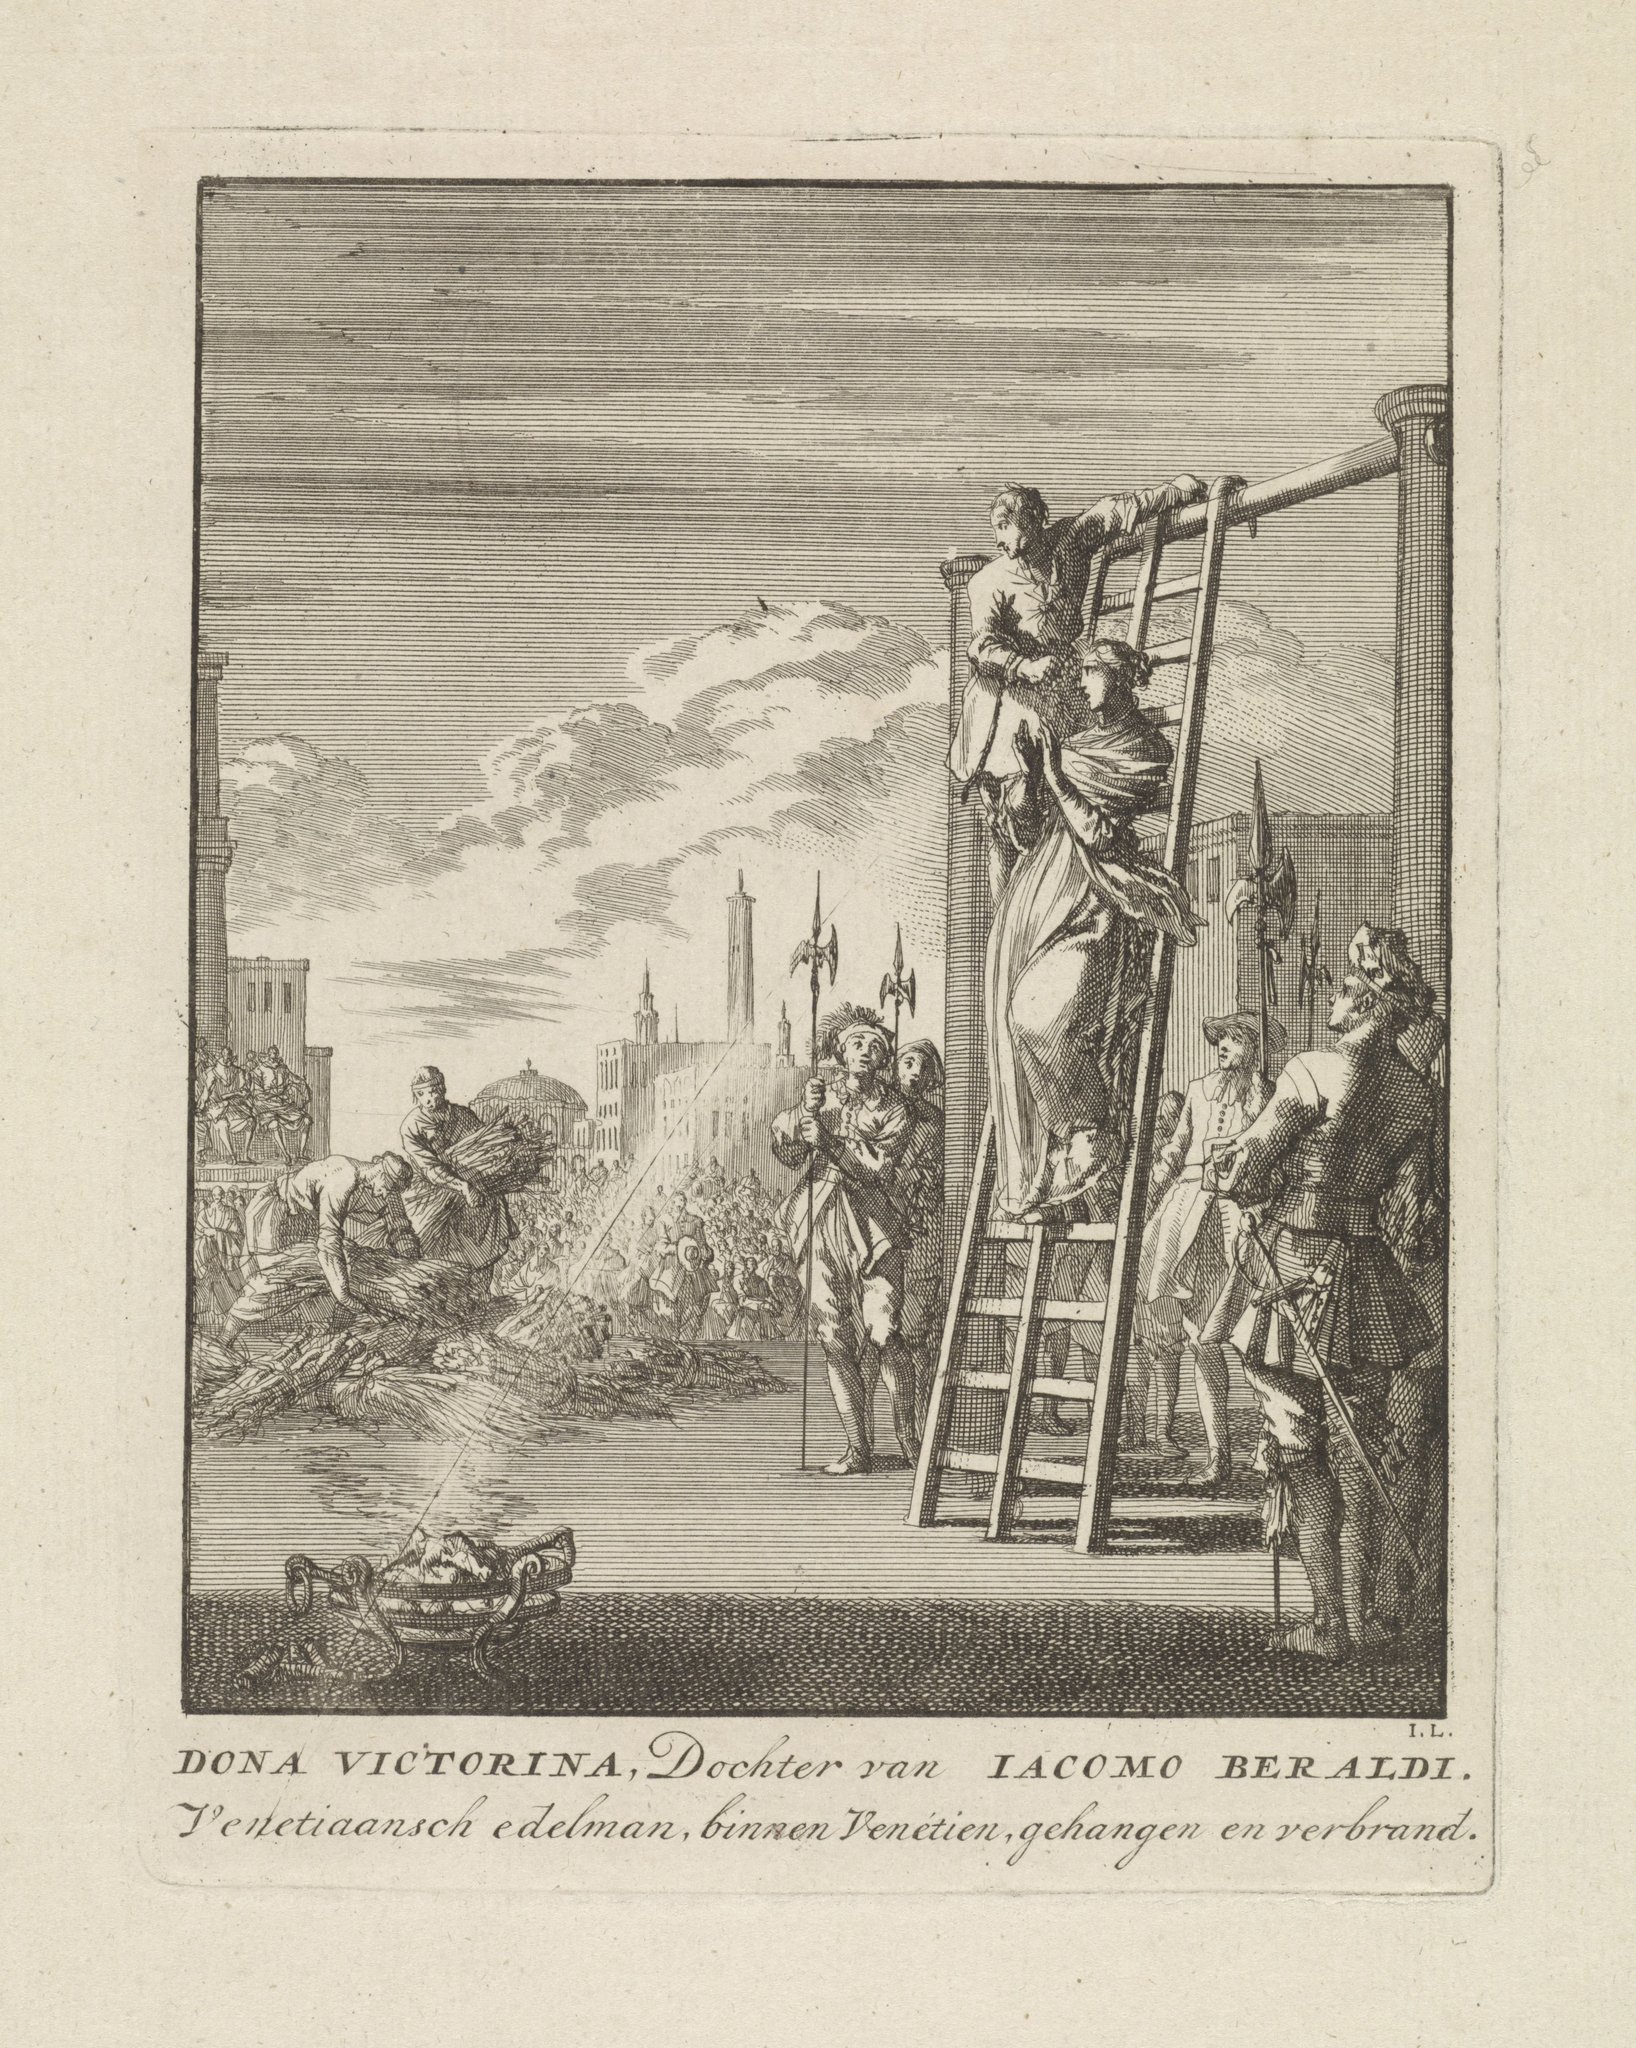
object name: history print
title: Dona Victorina, Dochter van Jacomo Beraldi, Venetiaansch edelman, binnen Venetien, gehangen en verbrand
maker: jan luyken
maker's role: draughtsman, print maker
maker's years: 1649-1712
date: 1699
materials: paper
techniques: etching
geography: amsterdam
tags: violent death by burning at the stake; pyre, on the scaffold or place of execution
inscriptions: collector's mark: Lugt 2228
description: Victorina, de dochter van de edelman Iacomo Beraldi, wordt aan een ladder gebonden om verbrand te worden. Ze wordt terechtgesteld vanwege de moord op haar man, Ludovico Fassino. Op de achtergrond verzamelen de beulen stro en hout voor de brandstapel.